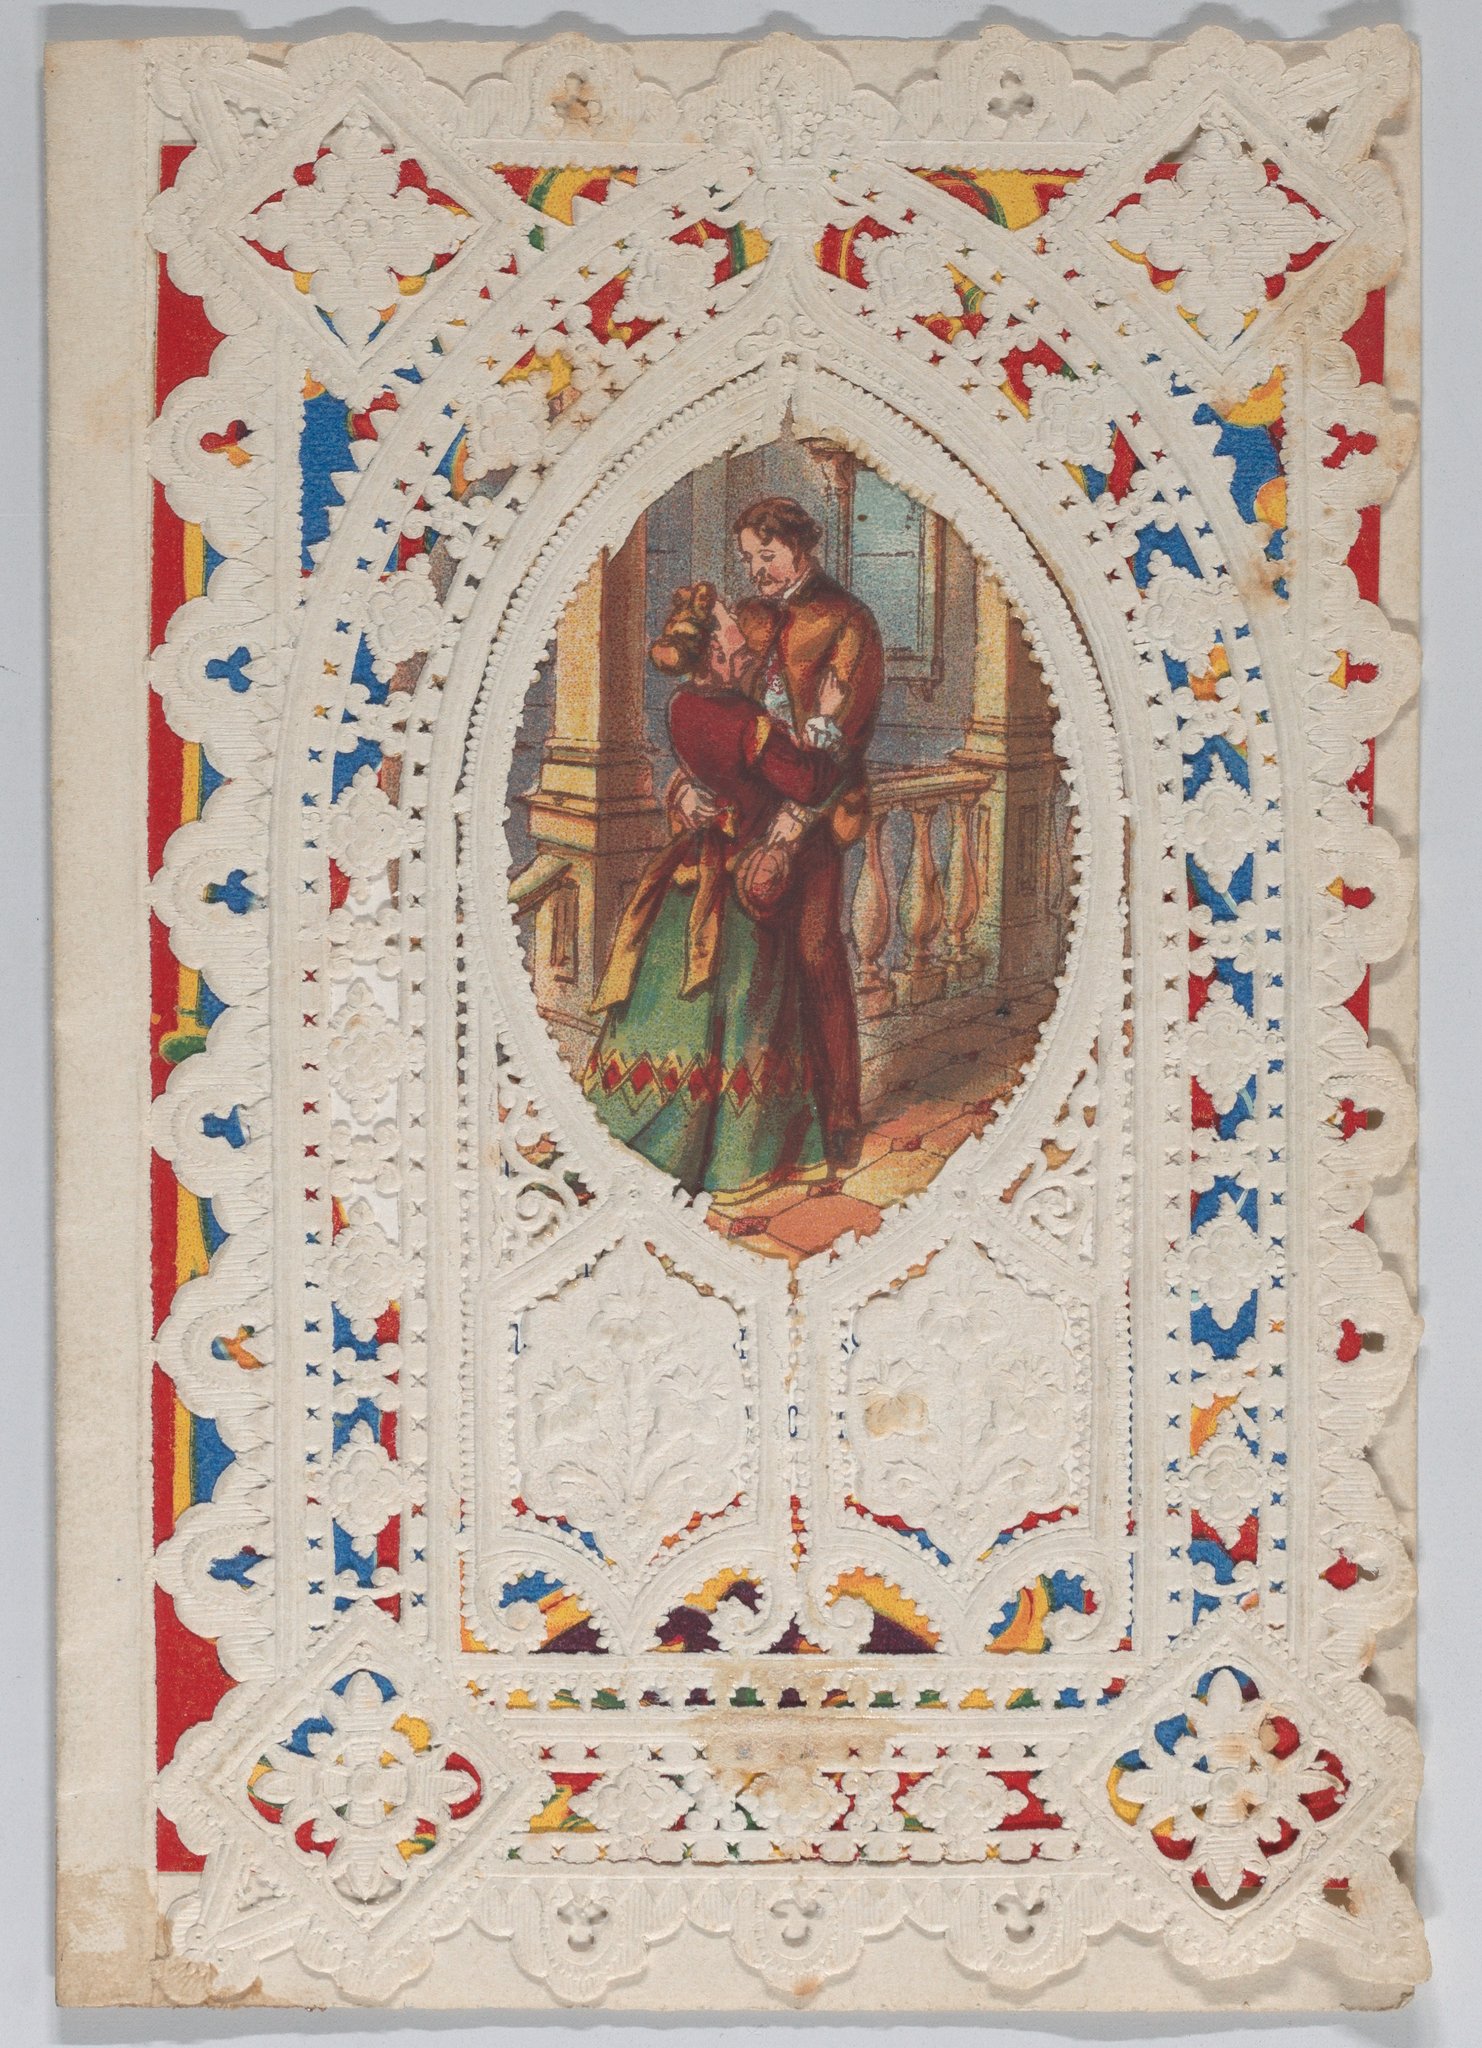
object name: valentine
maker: Anonymous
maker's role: artist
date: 1880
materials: lace, paper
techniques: chromolithography, embossing, open work